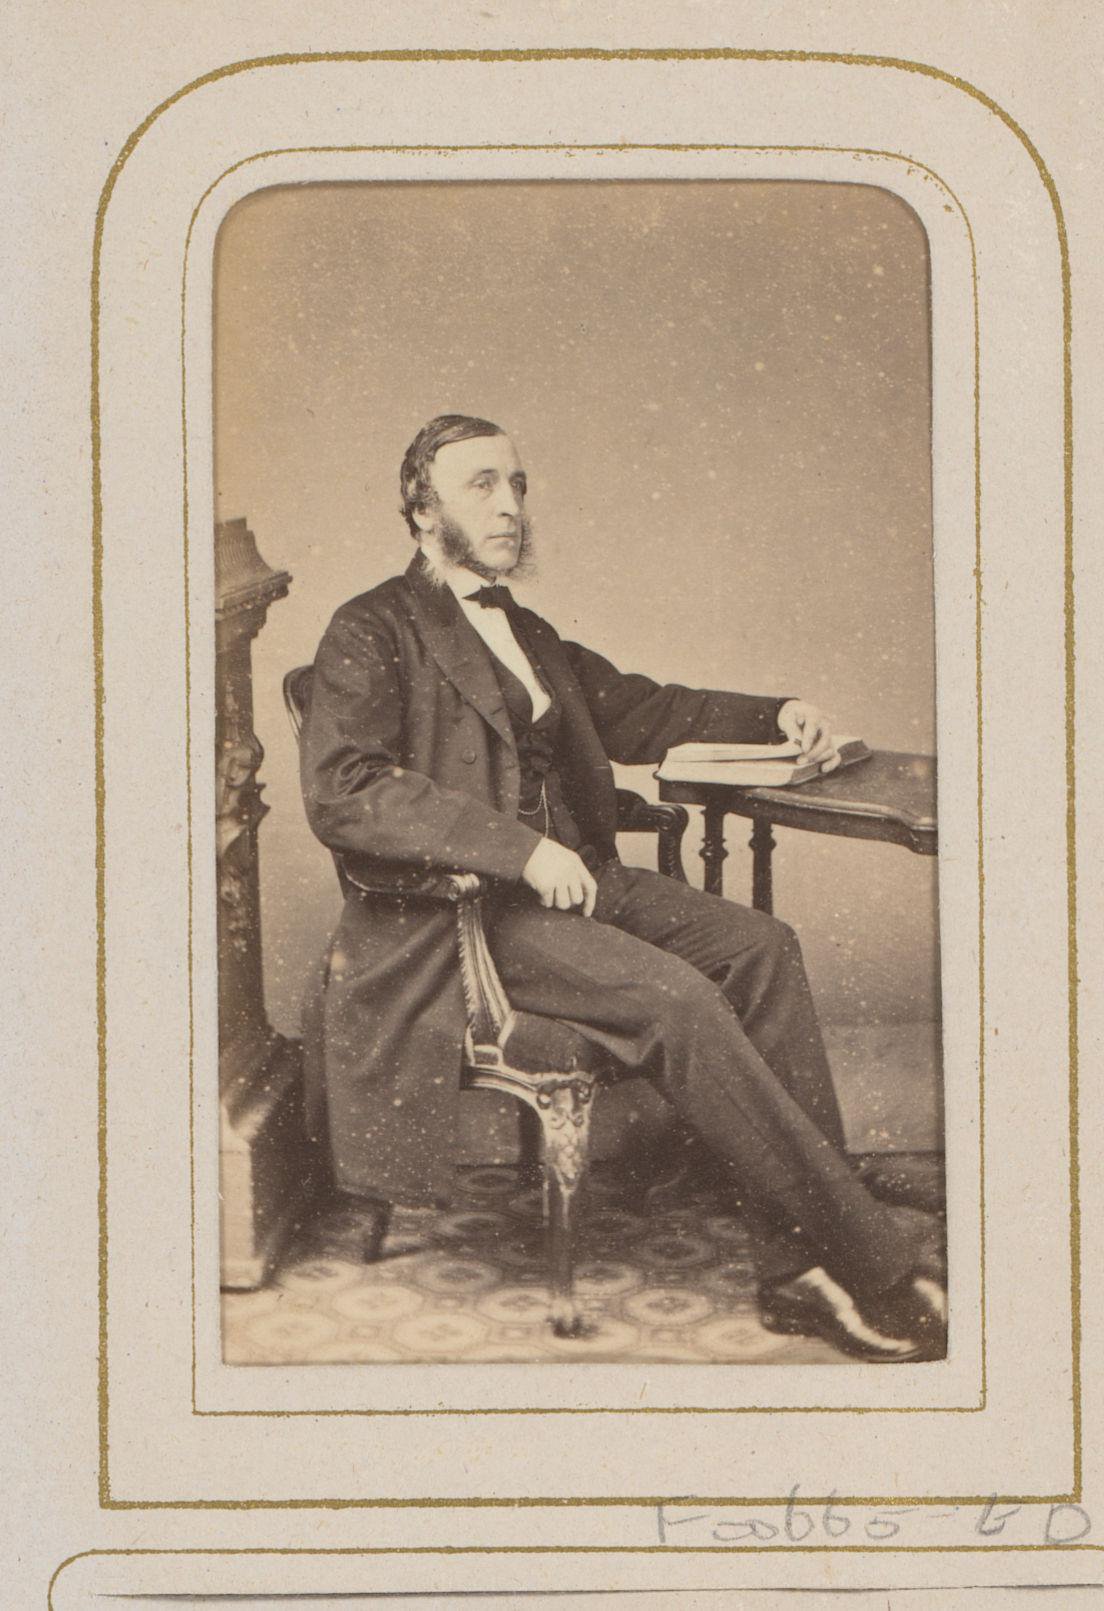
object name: album leaf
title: Portret van een man bij een tafel met boek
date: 1856-1865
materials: cardboard, photographic support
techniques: albumen print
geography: london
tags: historical persons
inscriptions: number: ‘97886’, inscription: ‘Maul & Polyblank/ Photographers/ 55, Gracechurch street/ 187a, Piccadilly/ and Tavistock House Fulham Road/ London’